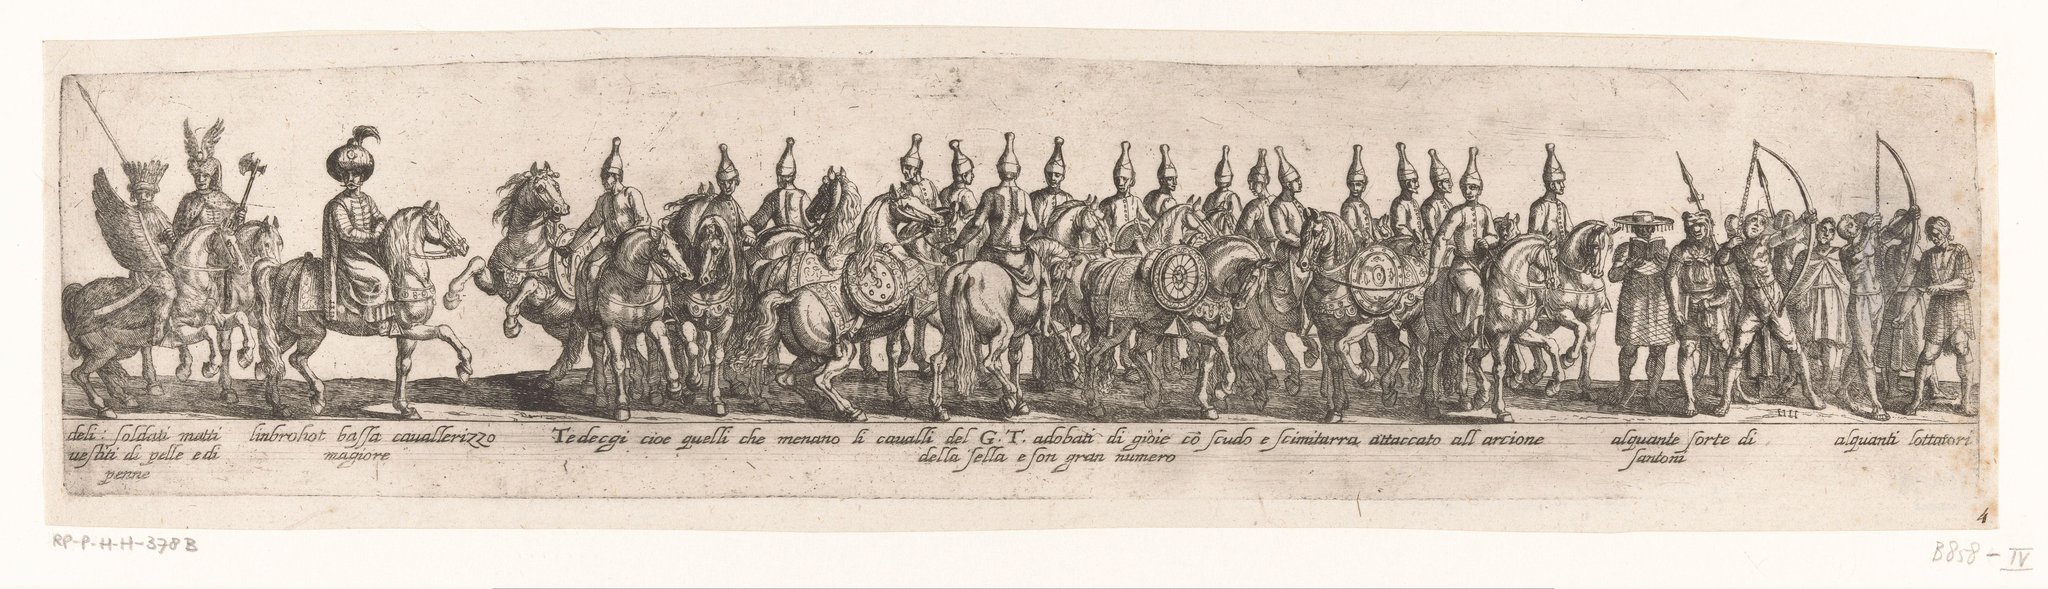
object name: print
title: Ordine che tiene il gran Turco quando cavalca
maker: antonio tempesta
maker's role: draughtsman, painter, print maker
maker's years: 1555-1630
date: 1565-1630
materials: paper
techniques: etching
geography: italy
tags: ceremonial procession, parade, pageant ~ installation of a ruler, festivities (+ the public ~ festive activities), head-gear: turban, warfare; military affairs (+ cavalry, horsemen)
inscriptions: number: ‘4’, collector's mark: ‘Hinloopen’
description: Deel van een parade met soldaten te paard en artiesten, vanwege het vertrek van een sultan. Bijschriften in het Italiaans in ondermarge.